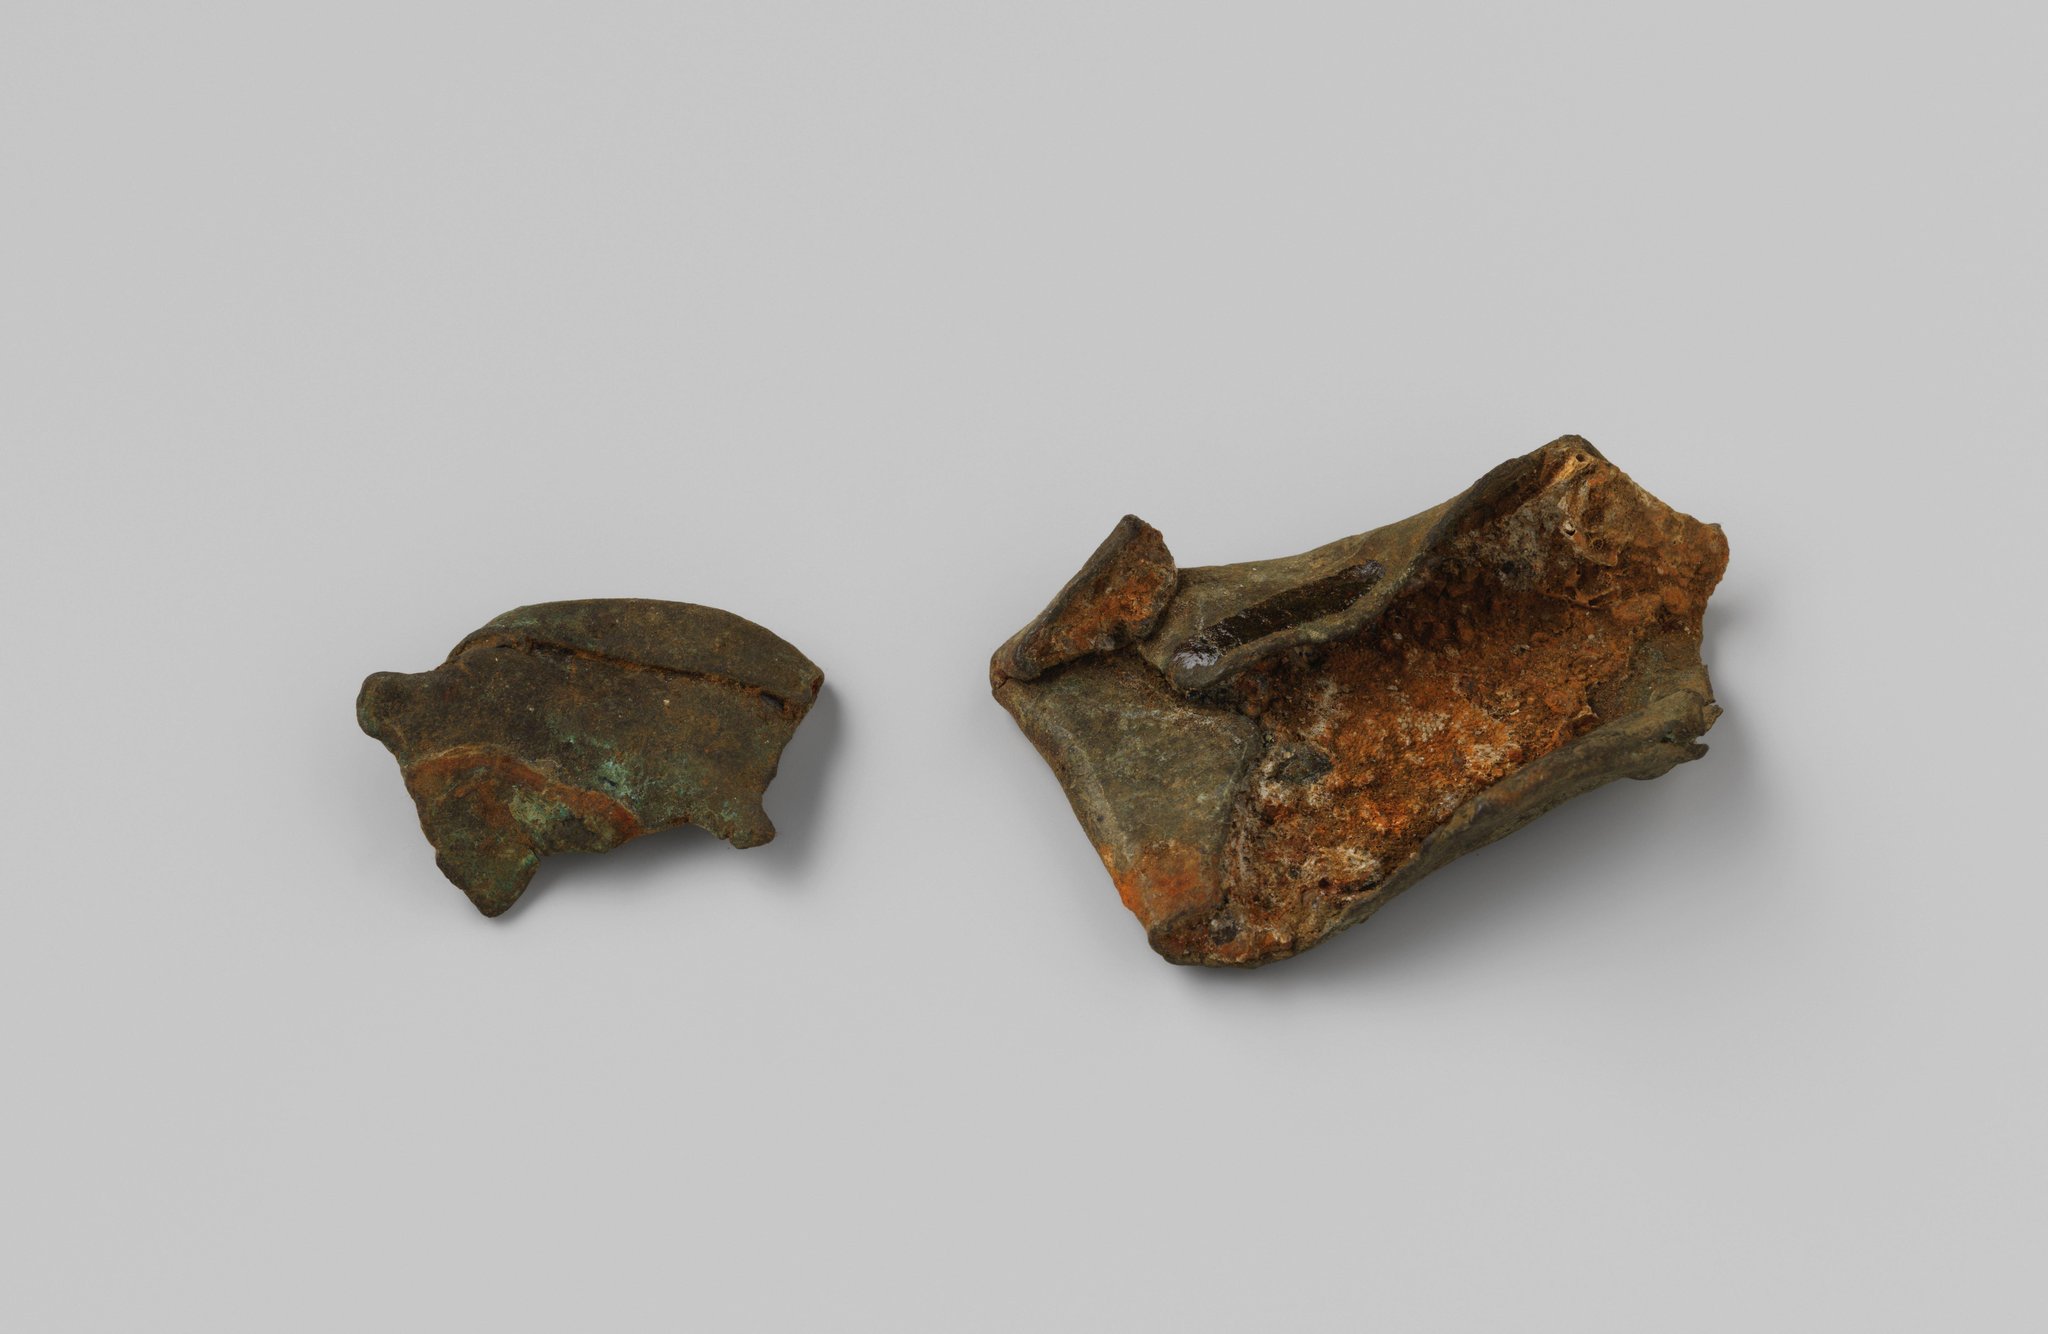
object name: fragment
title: Fragmenten koper uit het wrak van de Oost-Indiëvaarder Hollandia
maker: Anonymous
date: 1700-1743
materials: copper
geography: netherlands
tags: verenigde oostindische compagnie, hollandia (schip), annet